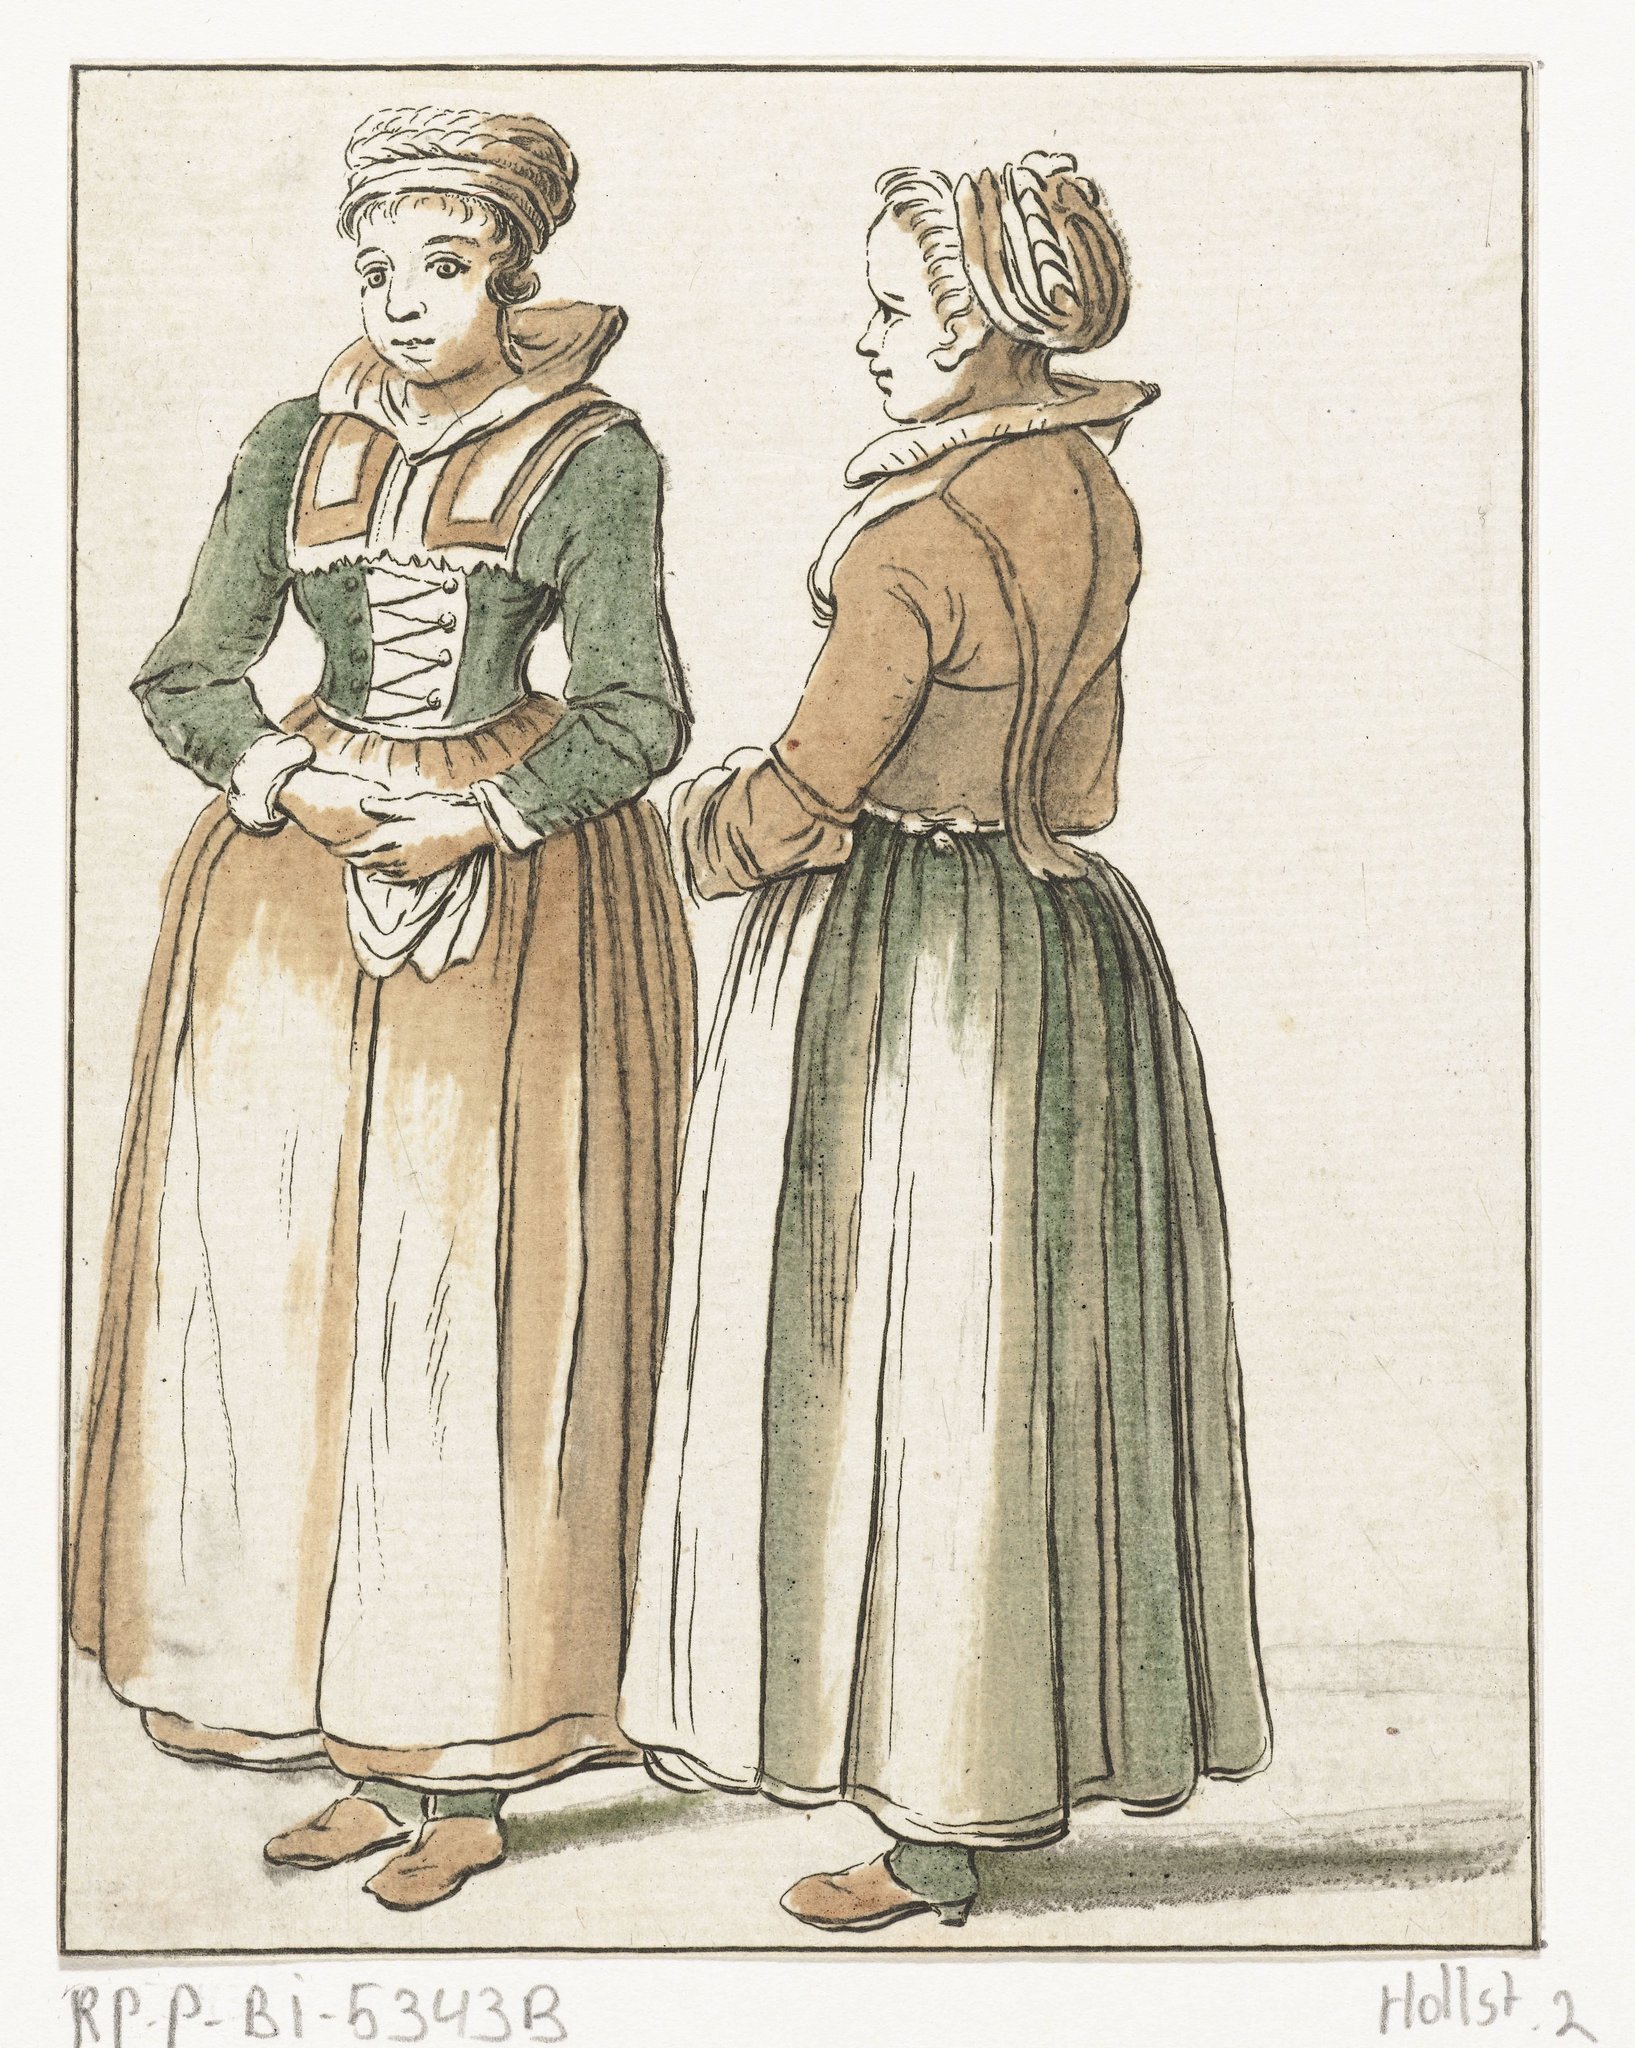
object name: print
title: Twee staande vrouwen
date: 1711-1781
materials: paper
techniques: etching, hand coloring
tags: folk costume, regional costume, the ages of man (+ young female (human being))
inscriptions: collector's mark: Lugt 2228, inscription:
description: Twee vrouwen in locale klederdracht. De een staat frontaal, de ander naar links gedraaid.